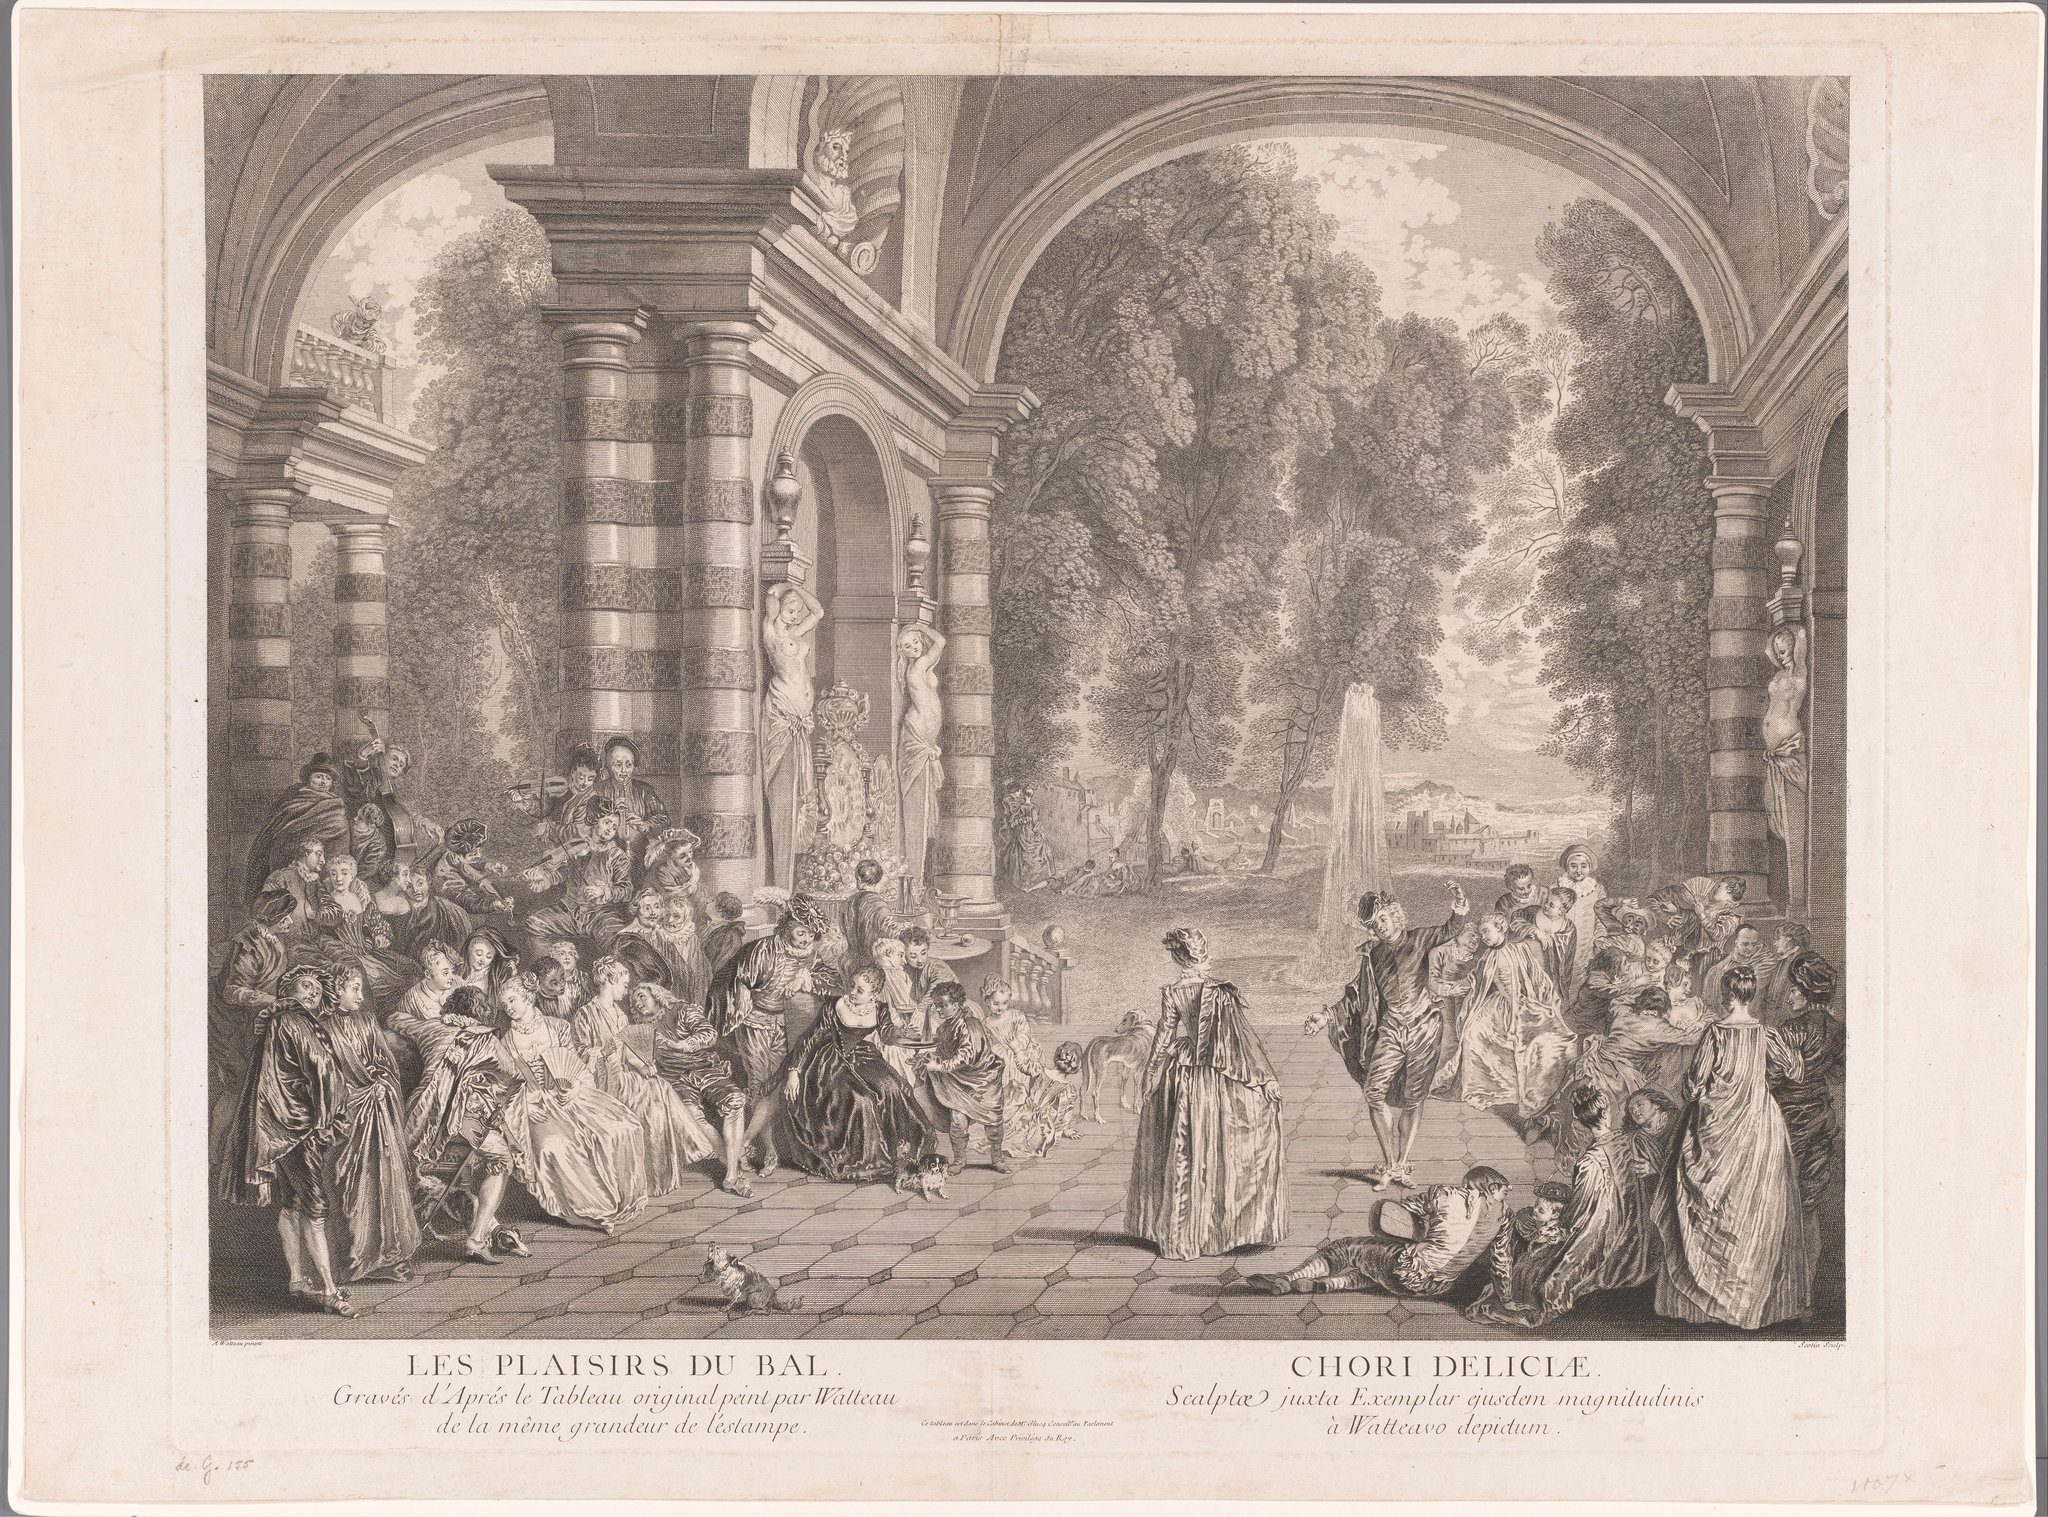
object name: print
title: Les Plaisirs du Bal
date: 1708-1733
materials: paper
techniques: engraving, etching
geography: france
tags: private festivities, merry company - aa - in the open air, 'fête champêtre'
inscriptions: collector's mark: Lugt 2228